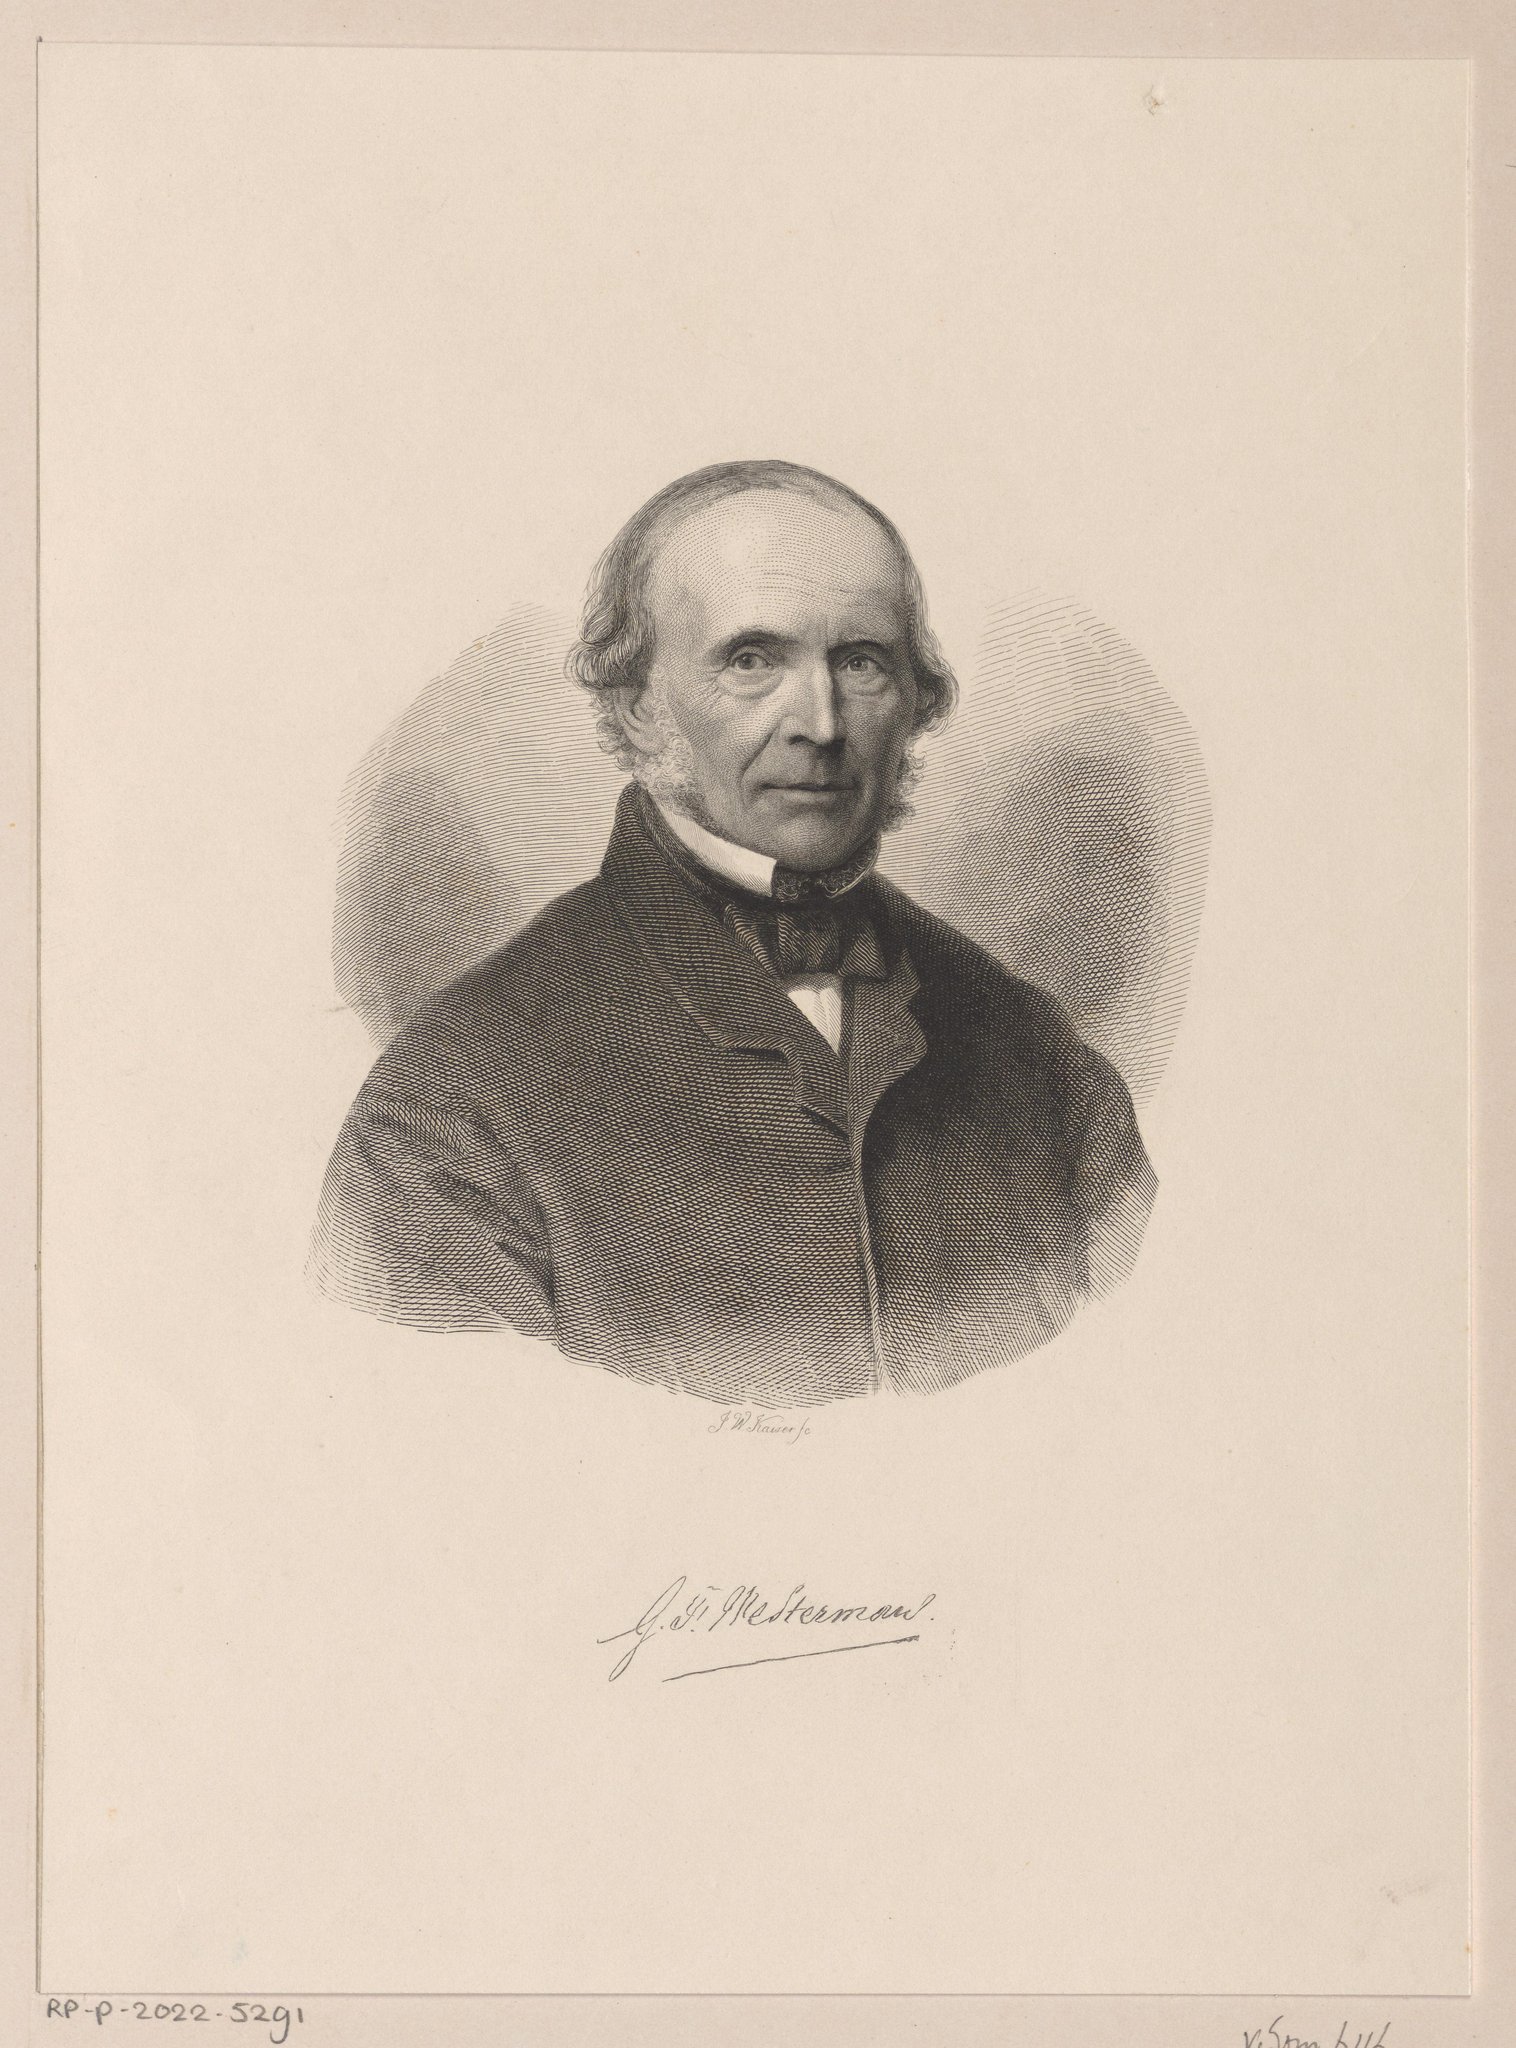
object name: print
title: Portret van Gerardus Frederik Westerman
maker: johann wilhelm kaiser (i)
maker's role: draughtsman, print maker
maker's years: 1813-1900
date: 1823-1891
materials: paper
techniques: engraving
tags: rotterdam, gerardus frederik westerman, historical persons